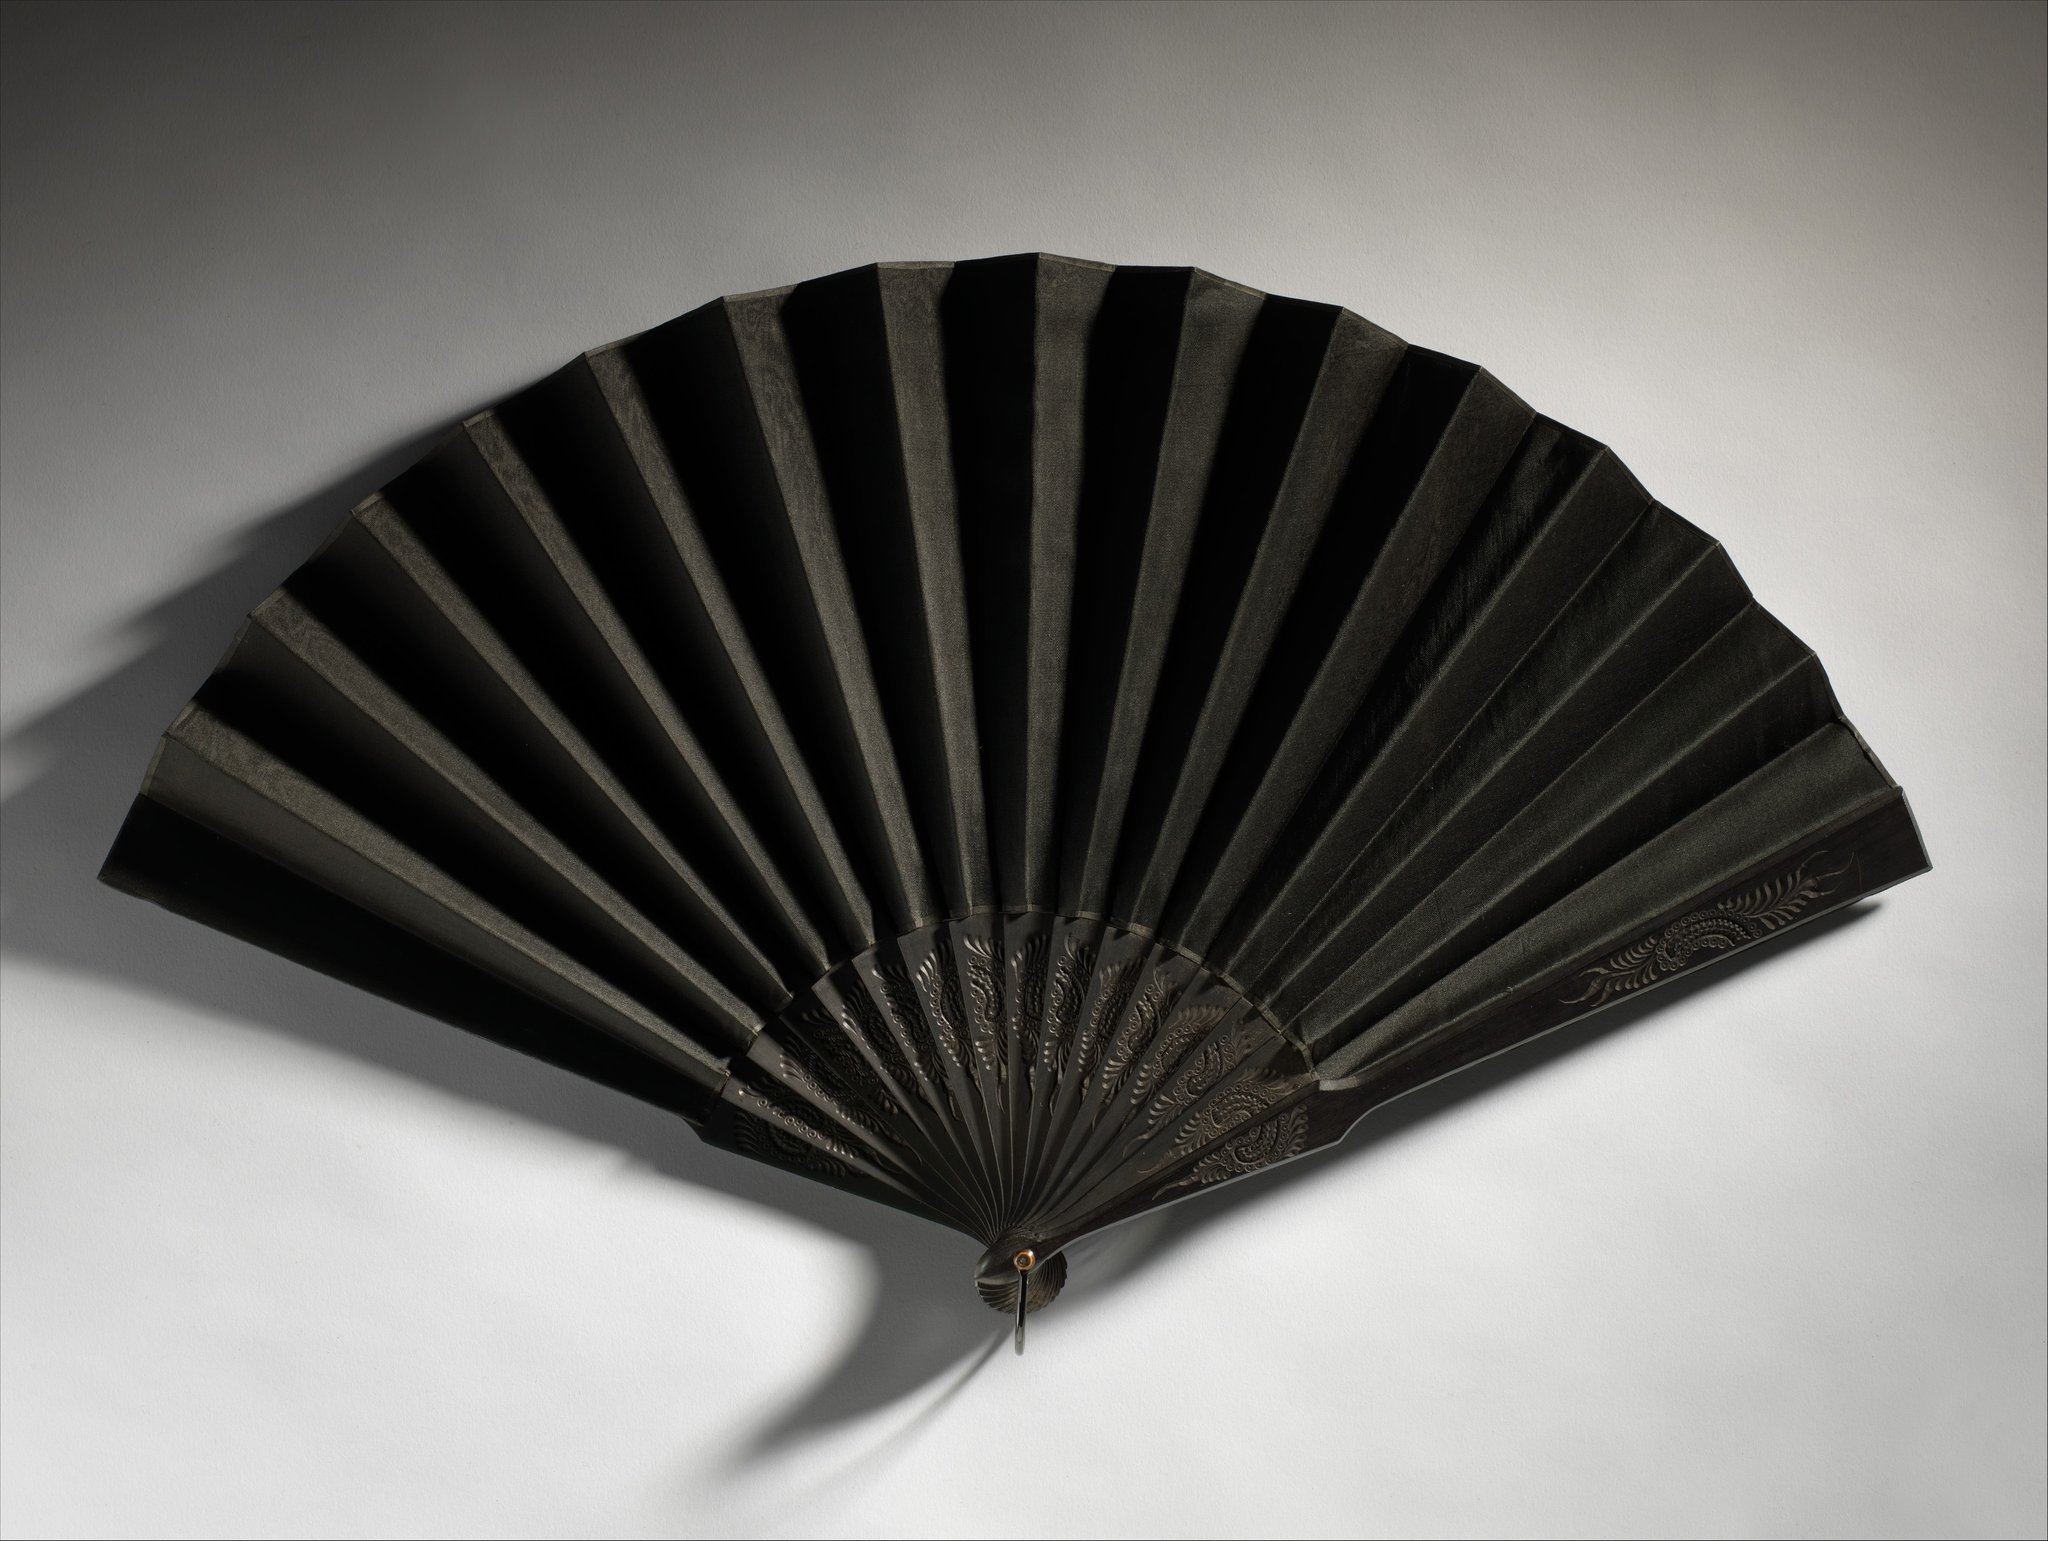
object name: mourning fan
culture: american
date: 1880-1885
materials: silk, wood